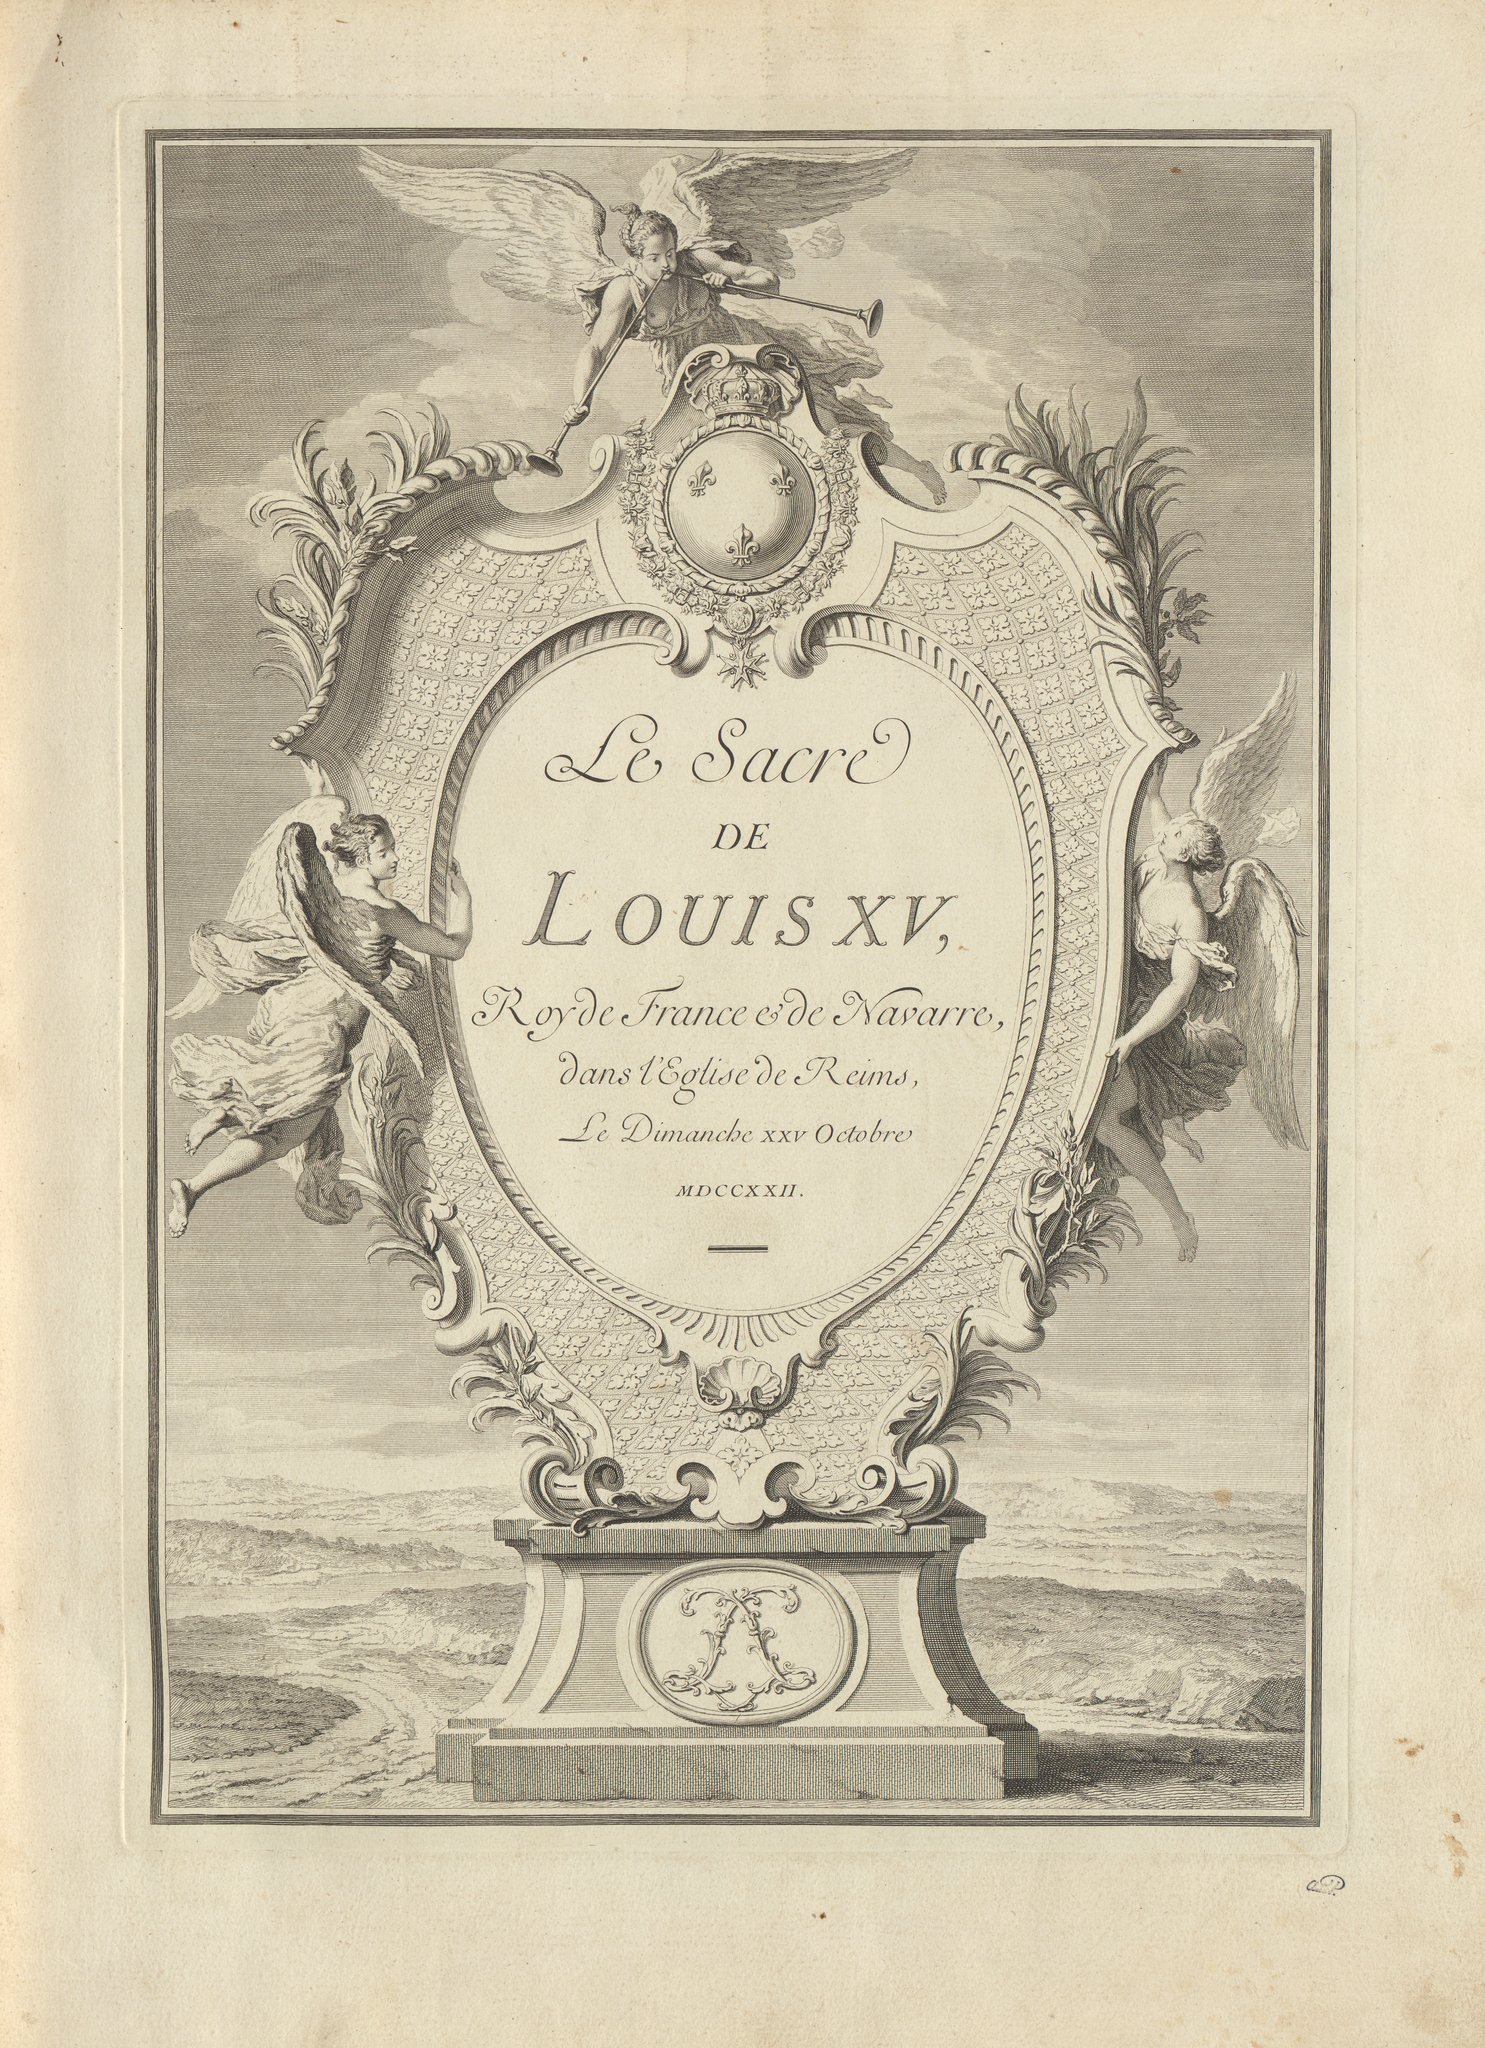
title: Le sacre de Louis XV, roy de France & de Navarre, dans l'église de Reims, le dimanche XXV octobre MDCCXXII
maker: pierre dulin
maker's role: artist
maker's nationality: french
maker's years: 1669-1748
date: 1723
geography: france